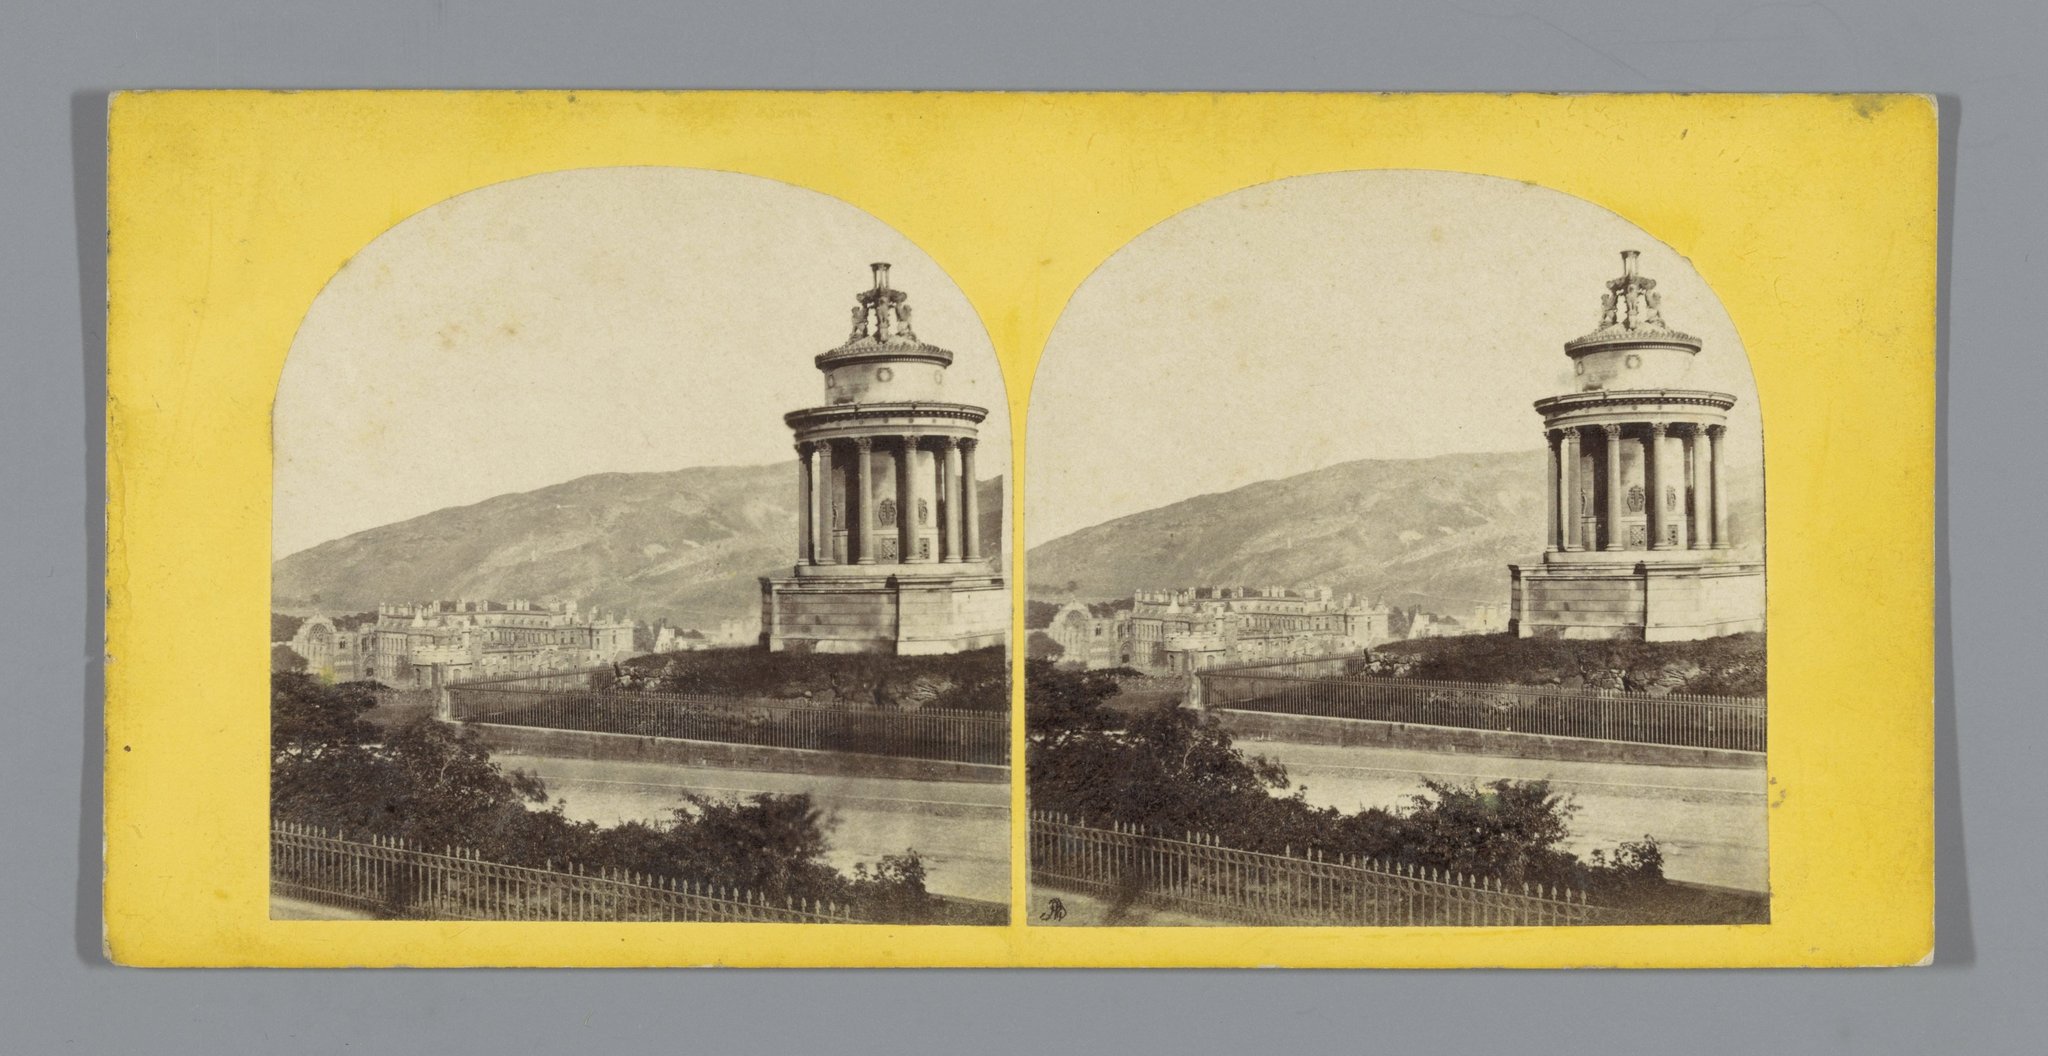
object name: stereograph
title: Gezicht op een monument voor Robert Burns in Edinburgh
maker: Anonymous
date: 1850-1880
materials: cardboard, photographic support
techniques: albumen print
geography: edinburgh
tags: monument, statue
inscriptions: inscription: ‘Burns' Monument, Edinburgh.’